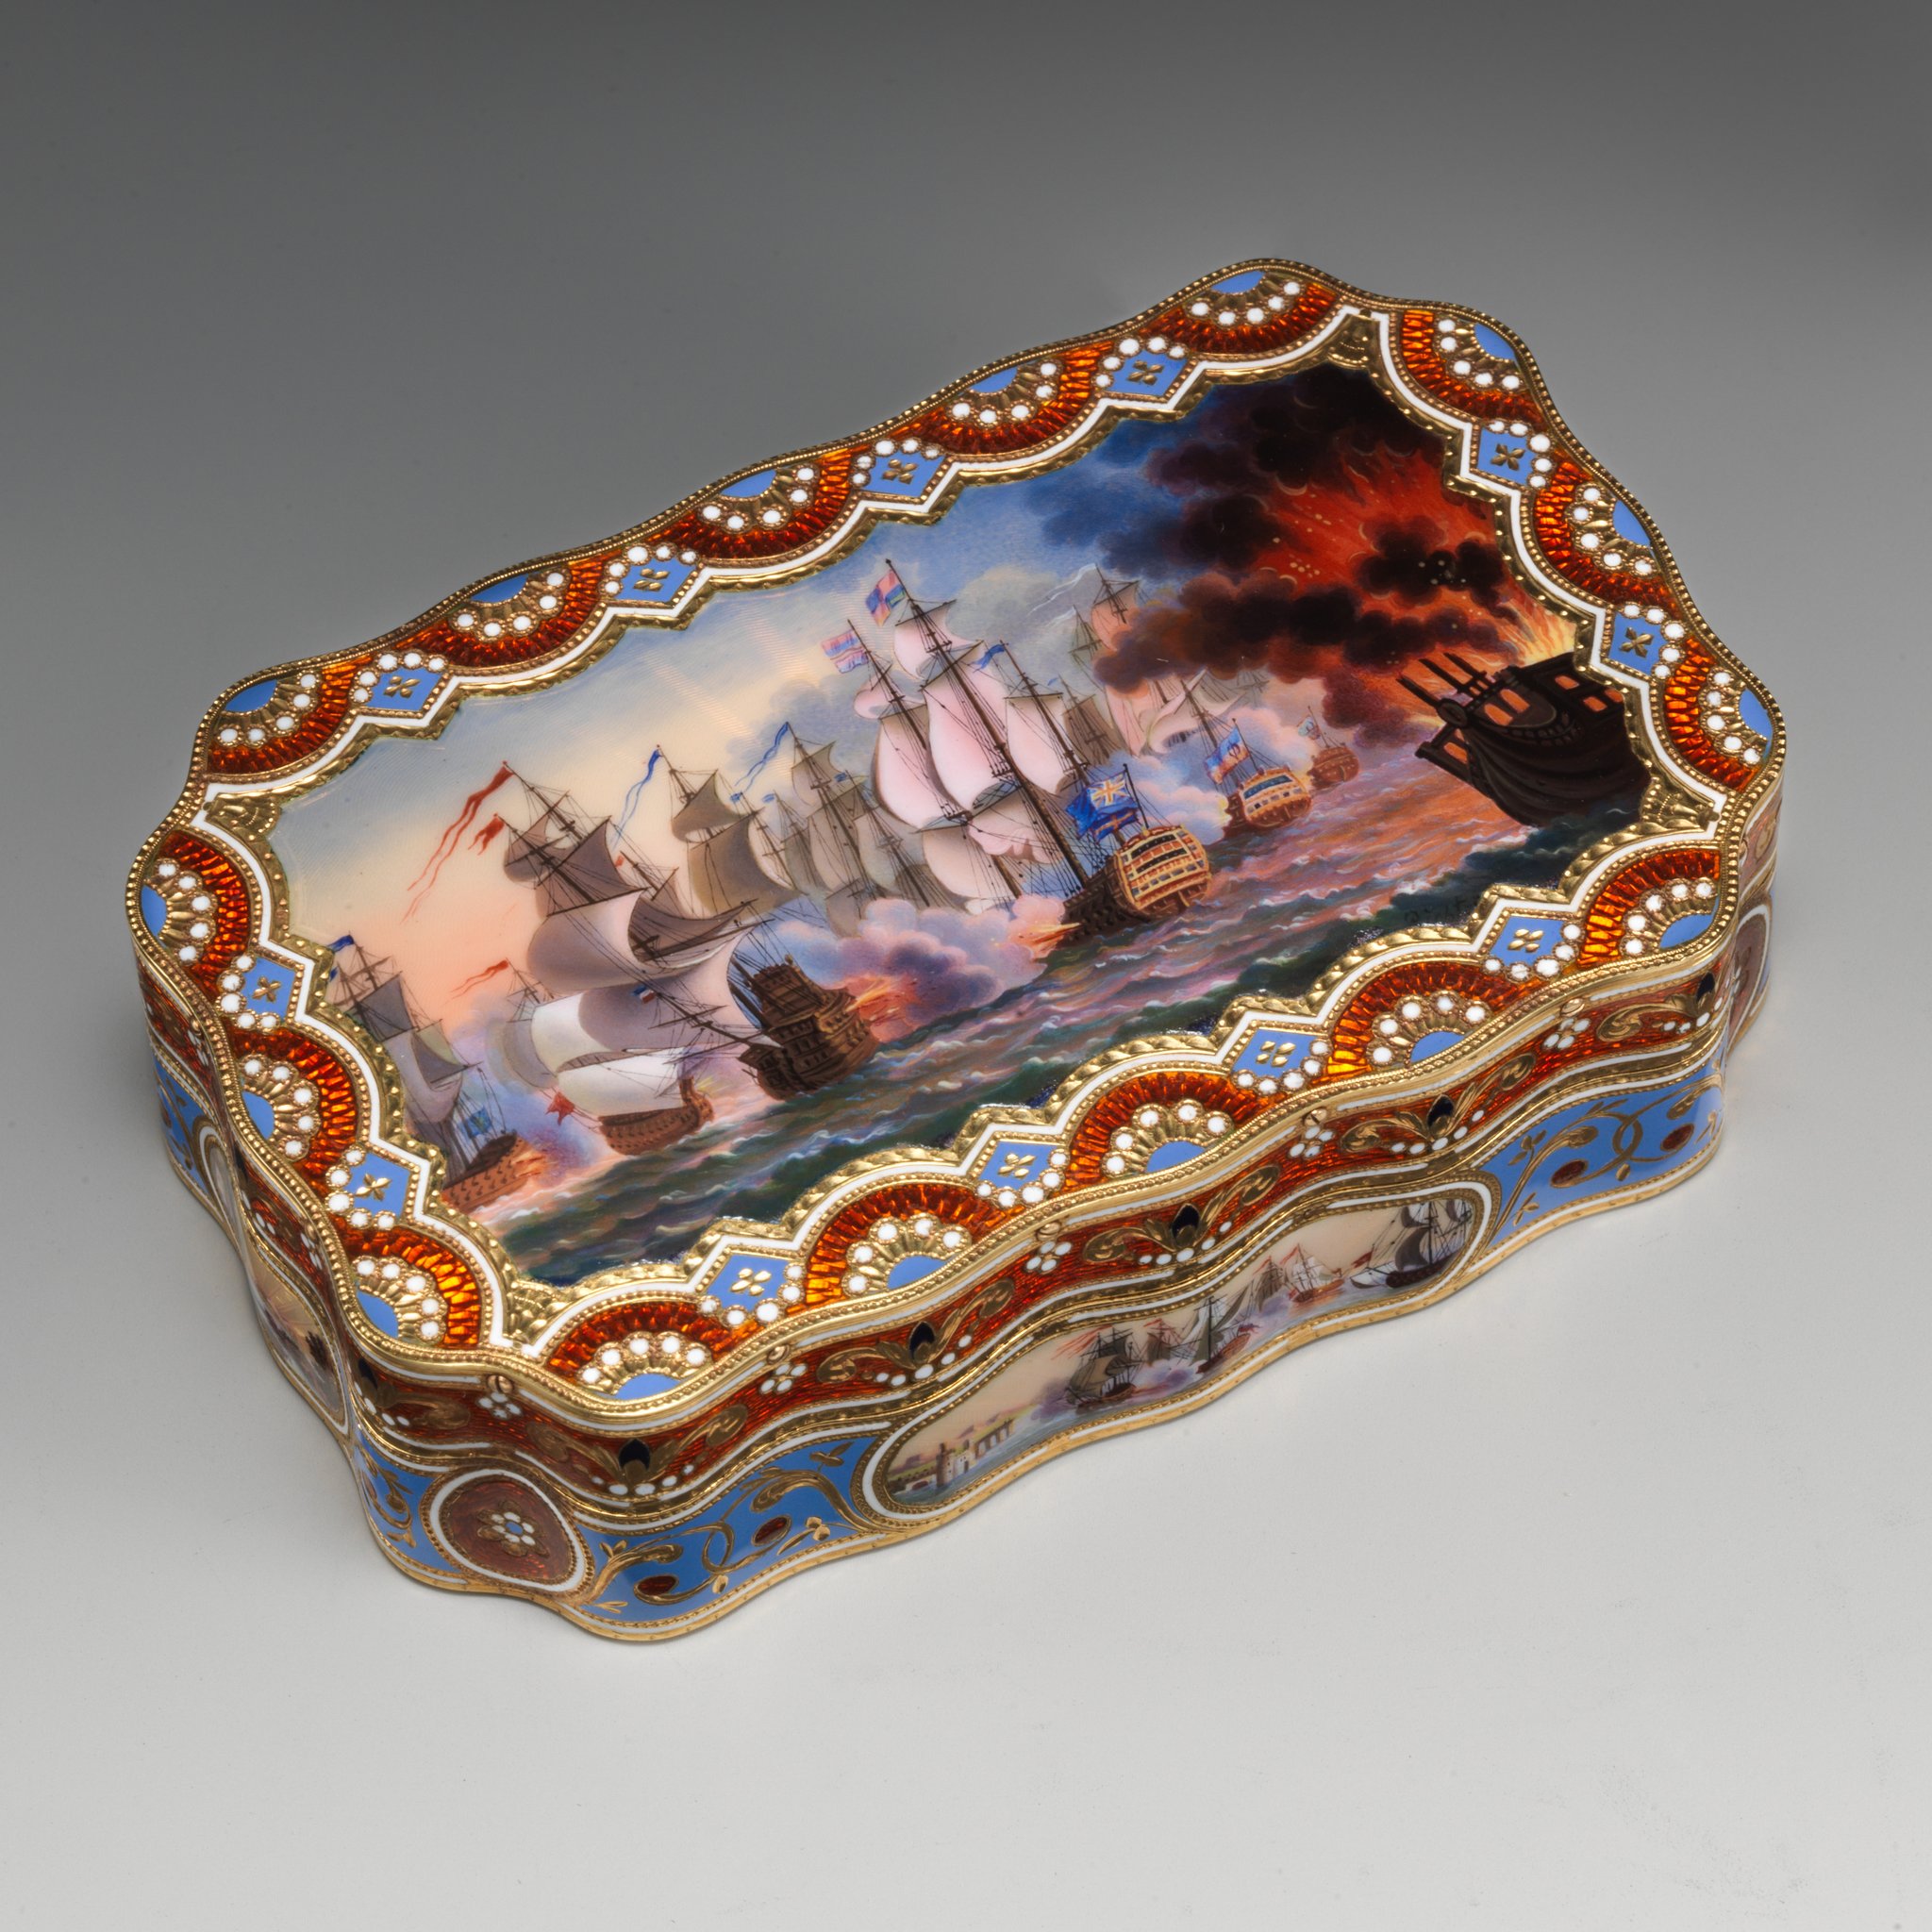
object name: snuffbox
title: Snuffbox with naval battle scenes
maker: jean louis richter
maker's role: enameler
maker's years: 1766-1841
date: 1825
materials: enamel, gold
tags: cannons,landscapes,ships